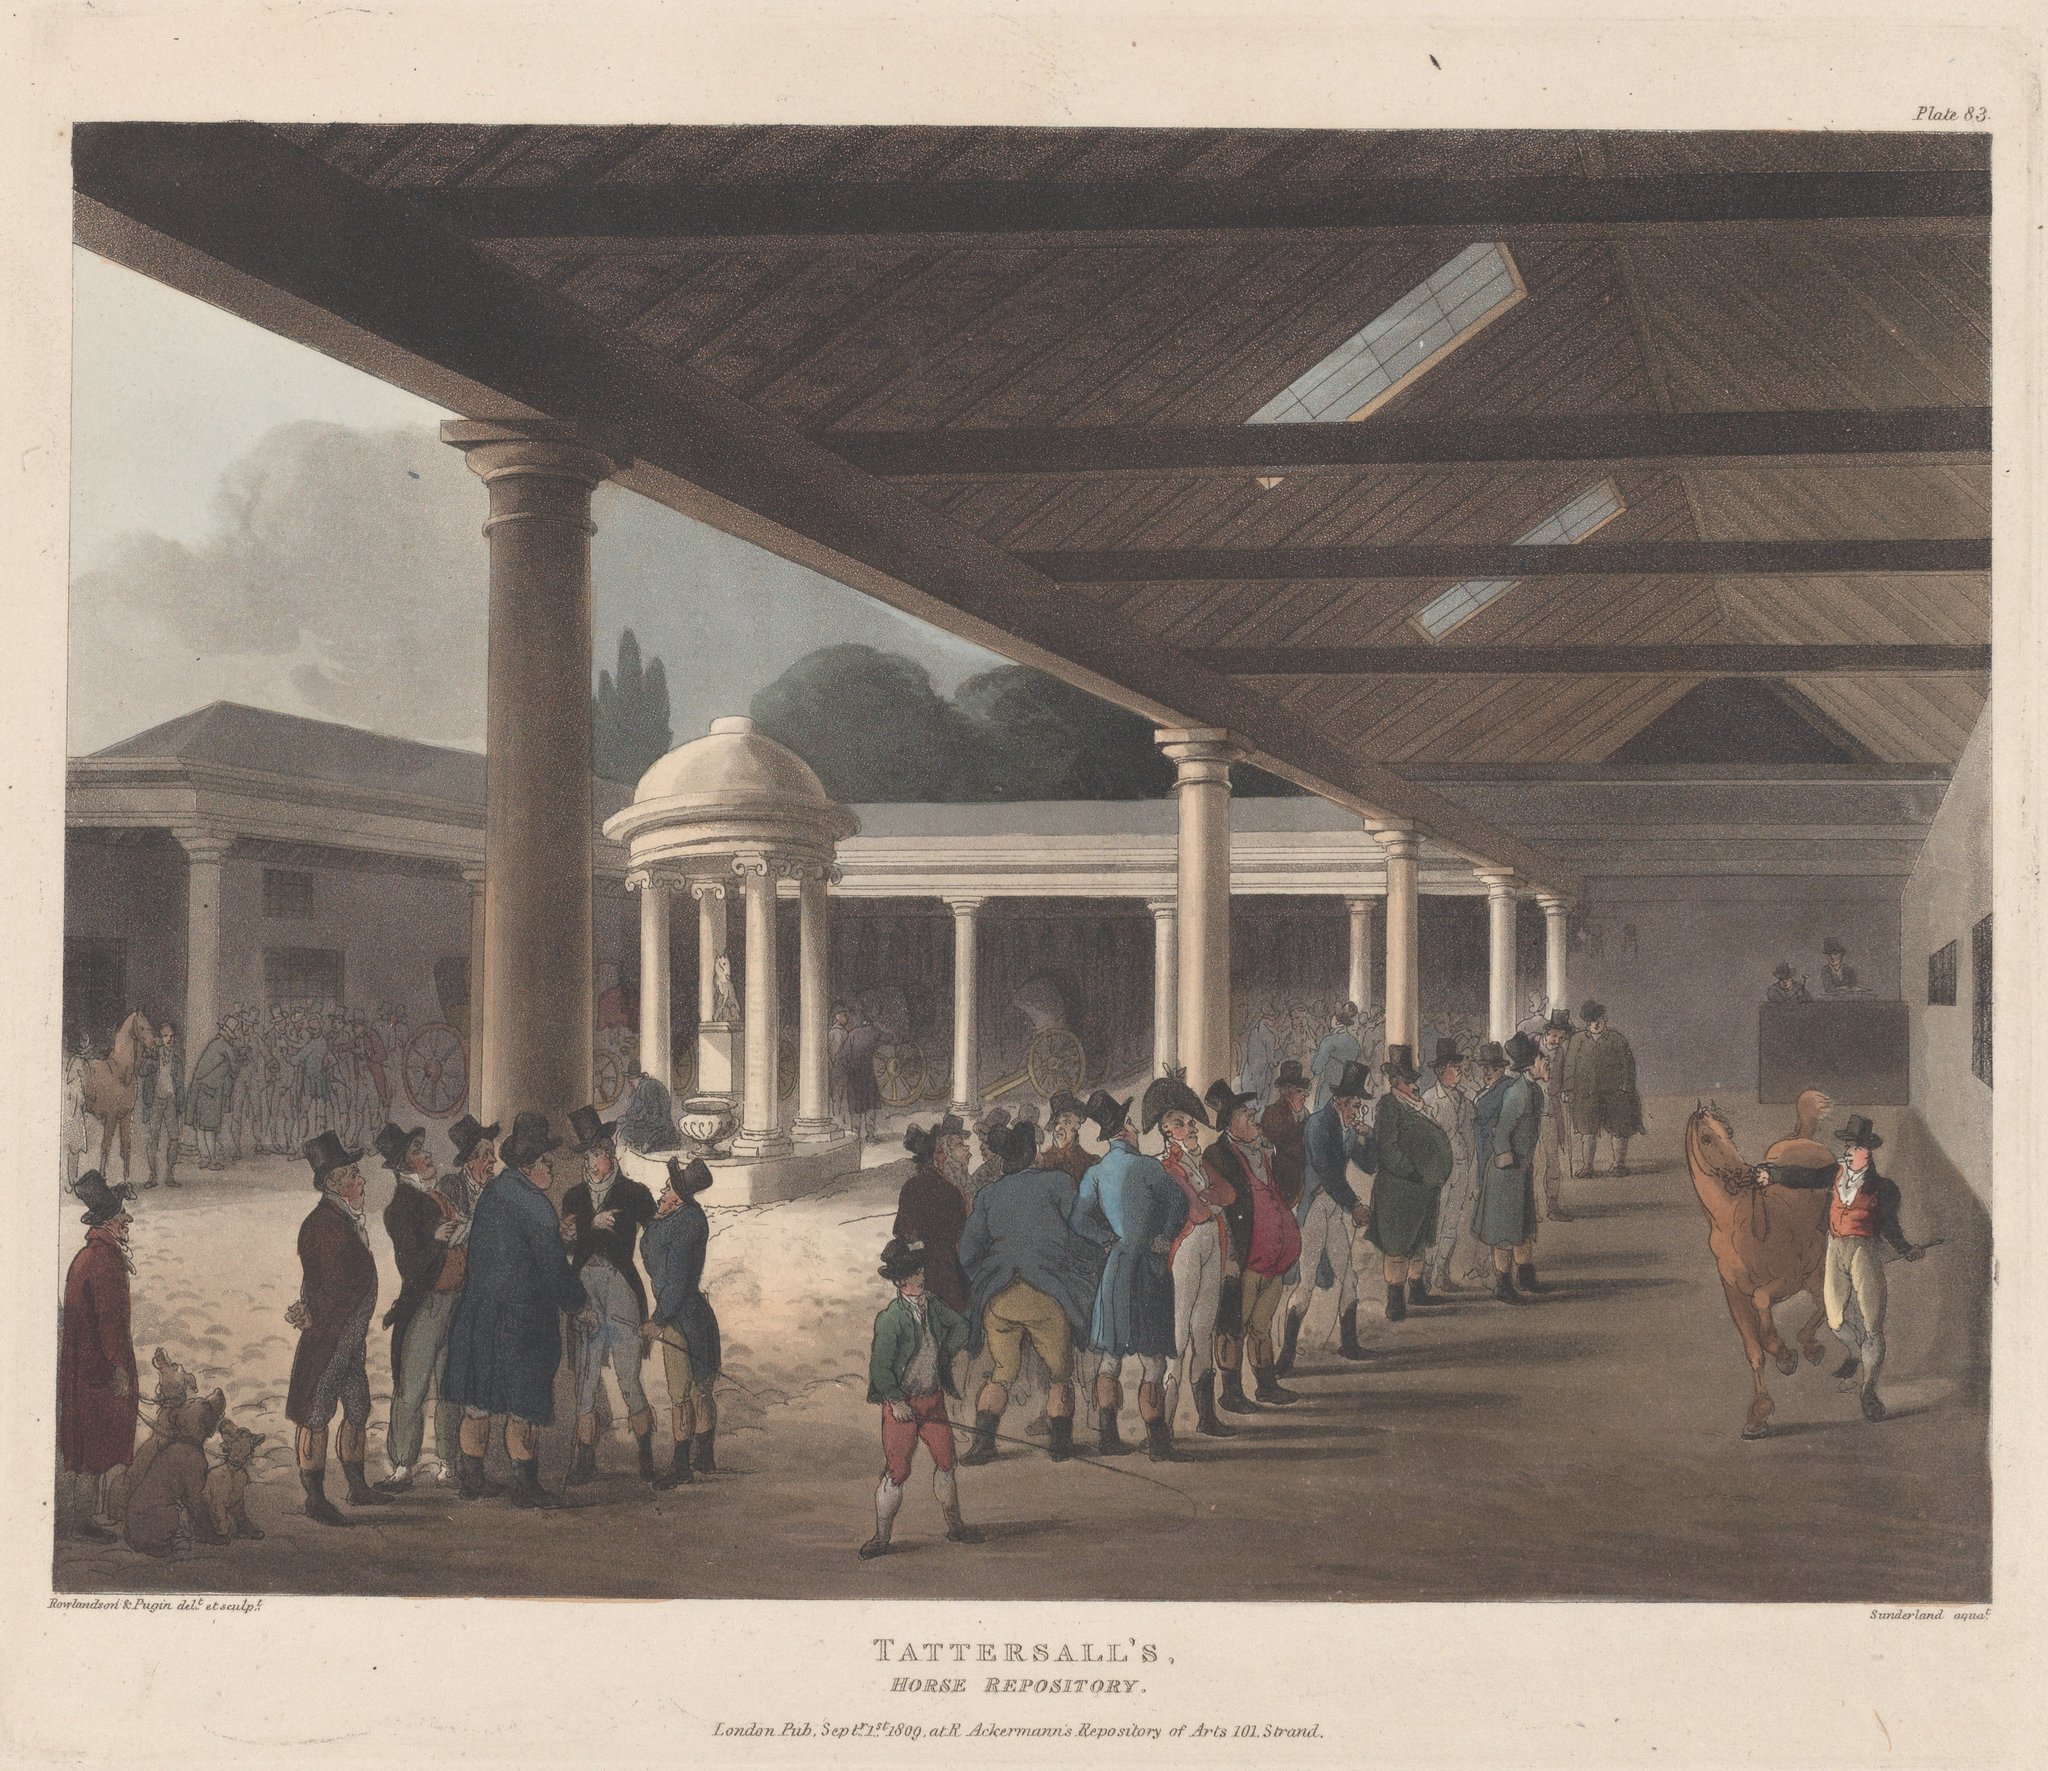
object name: print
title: Tattersall's, Horse Repository, Hyde Park Corner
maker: thomas rowlandson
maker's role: artist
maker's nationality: british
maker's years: 1757-1827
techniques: aquatint, etching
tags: men,horses,london